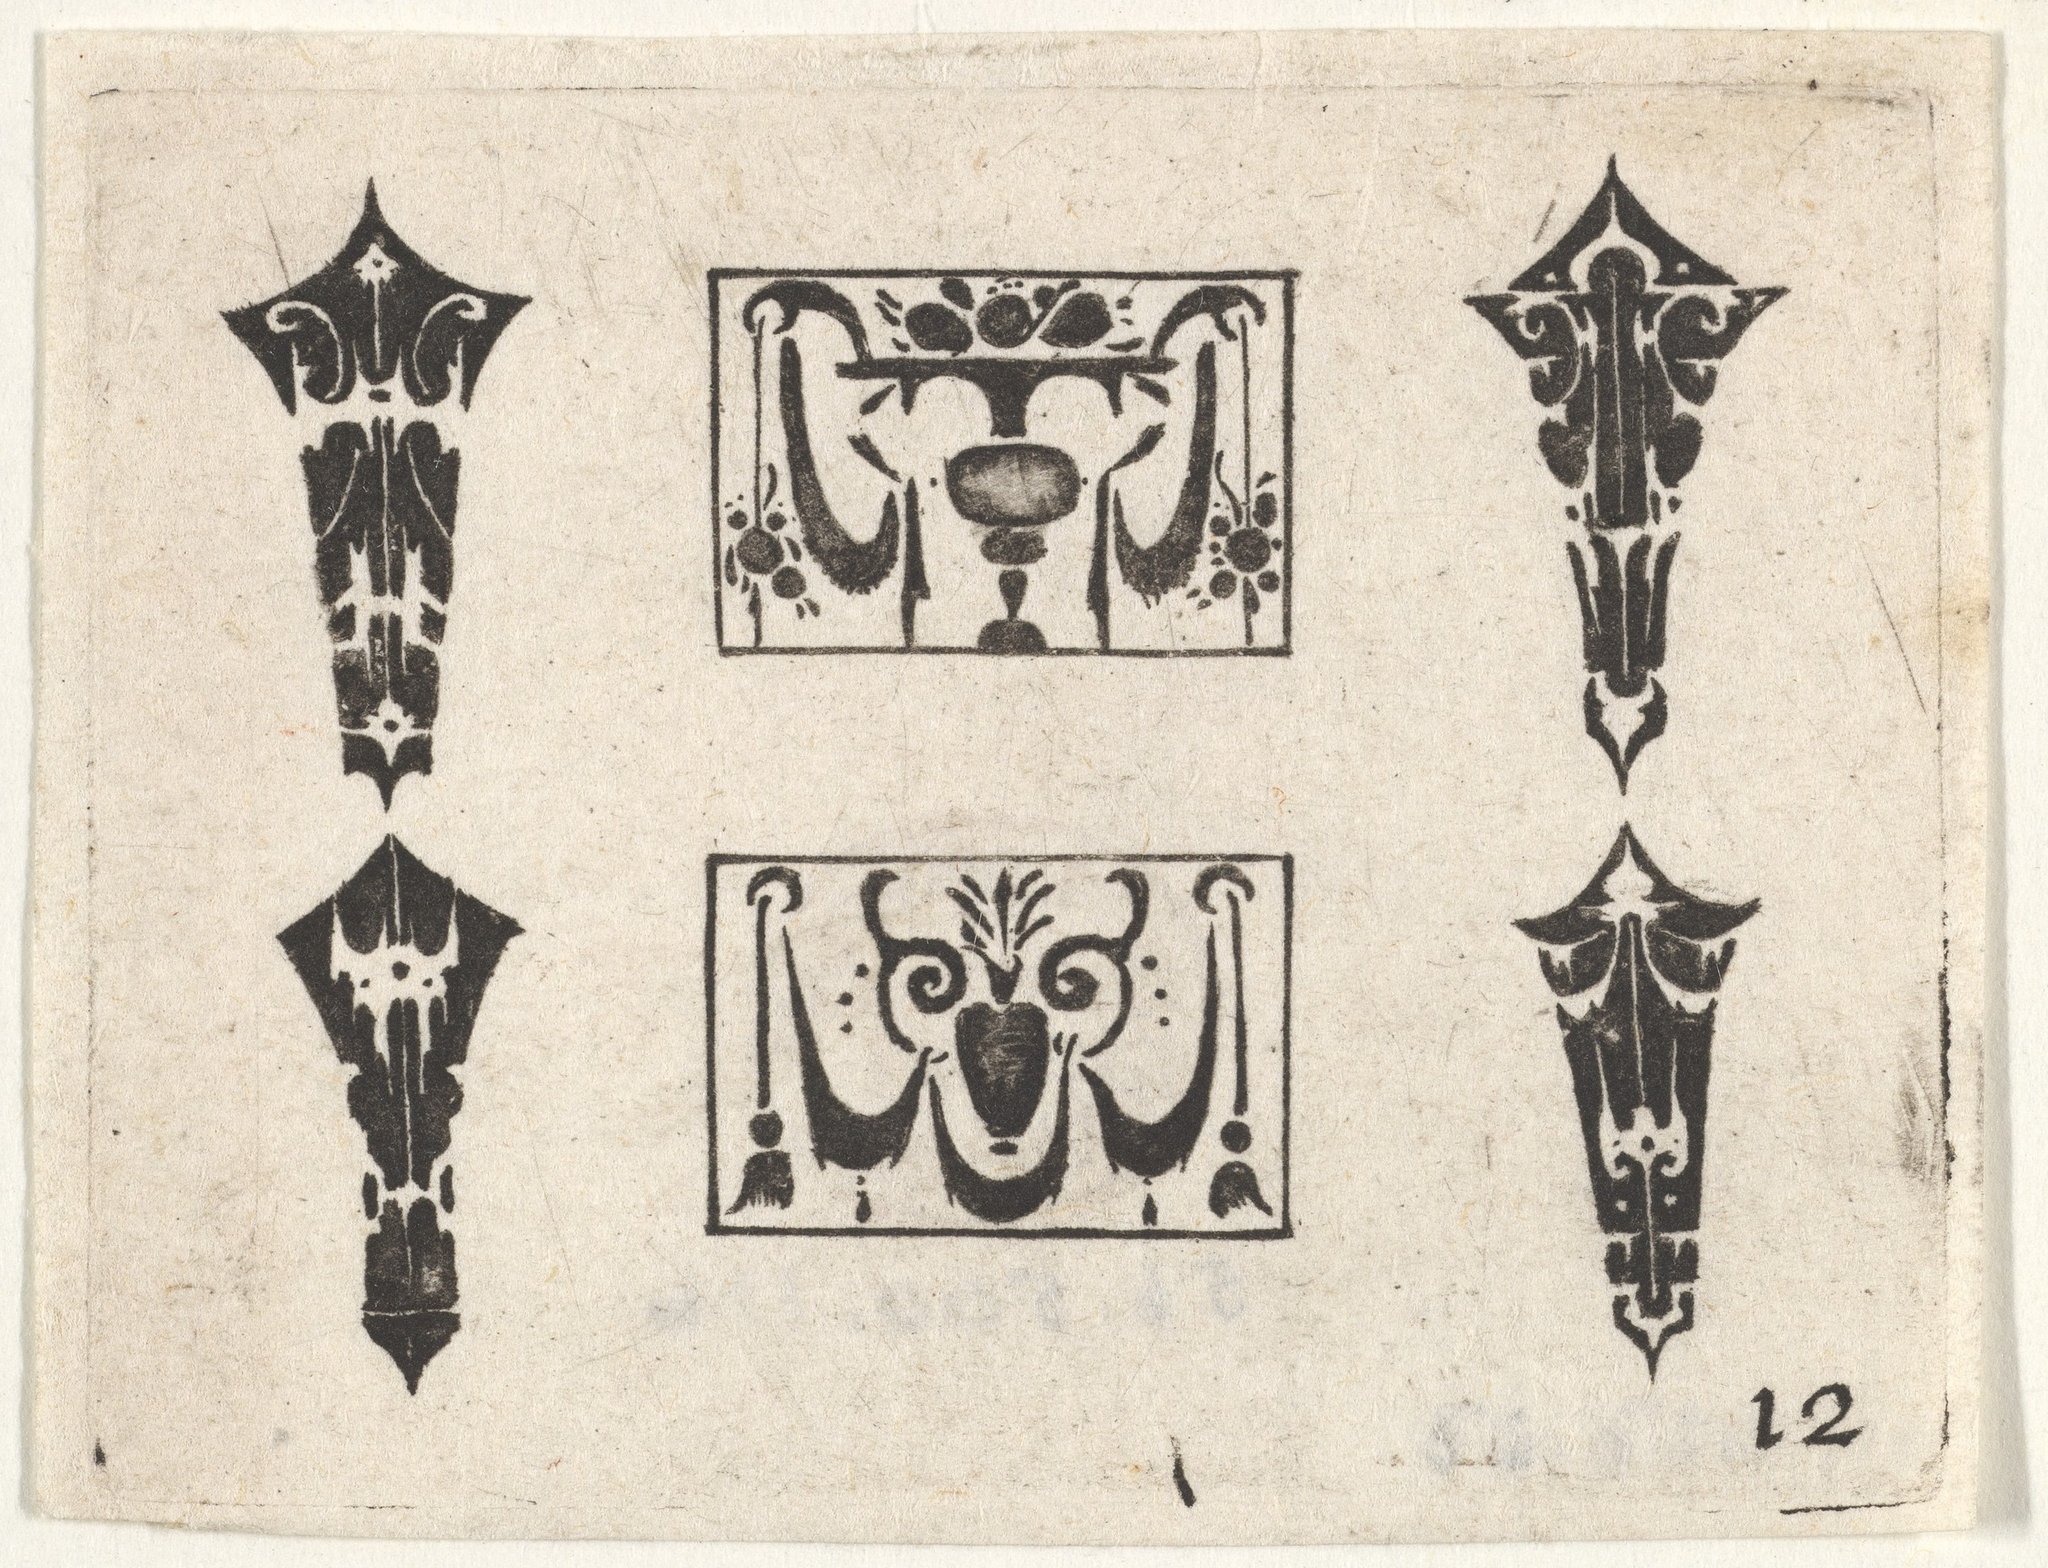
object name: print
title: Blackwork Print with Two Horizontal Panels and Four Bezels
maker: claes jansz. visscher (ii)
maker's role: artist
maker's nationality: dutch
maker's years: 1586-1652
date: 1620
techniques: embroidery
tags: ornament